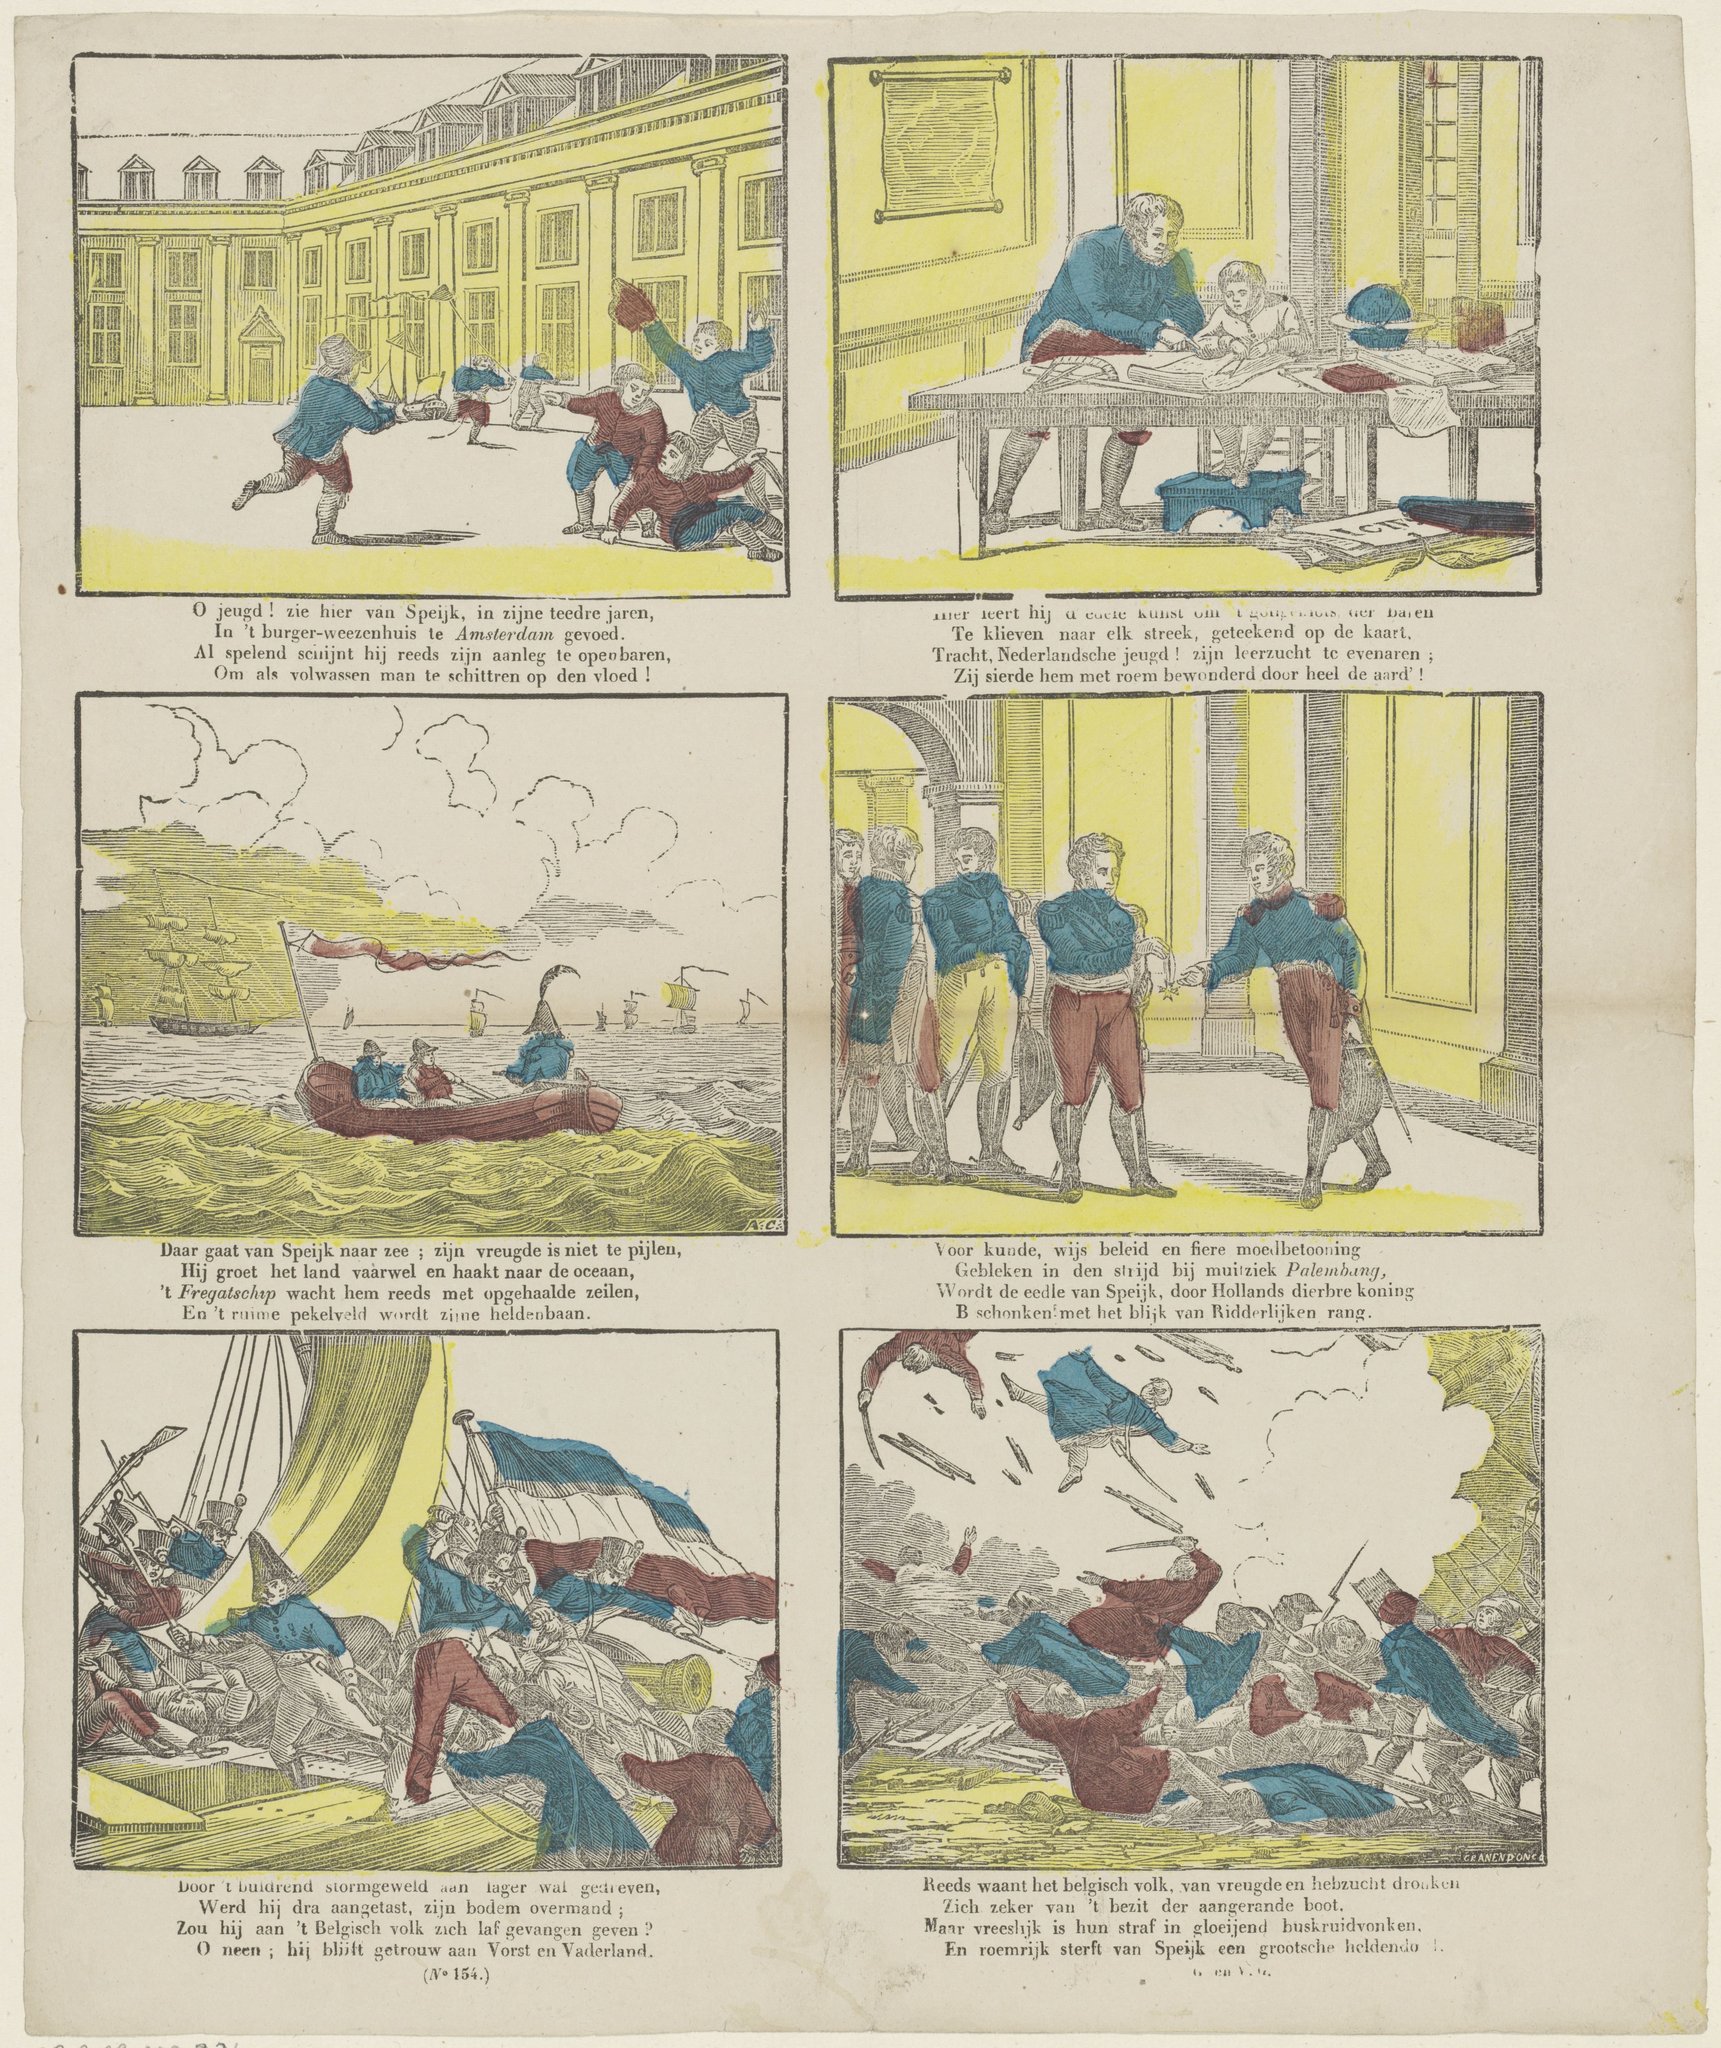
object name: print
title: Leven van Jan van Speyk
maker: alexander cranendoncq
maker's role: draughtsman, print maker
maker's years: 1799-1869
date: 1833-1856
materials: paper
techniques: colour, letterpress printing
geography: turnhout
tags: amsterdam, antwerp, jan van speyk, battle, revolution, revolt, orphans, belgium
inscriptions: collector's mark: Lugt 2760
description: Blad met 8 voorstellingen over het leven en de zelfopoffering van J.C.J. van Speyk tijdens de strijd tegen de Belgen. Onder elke afbeelding een vierregelig vers. Genummerd linksonder: (No 154.).